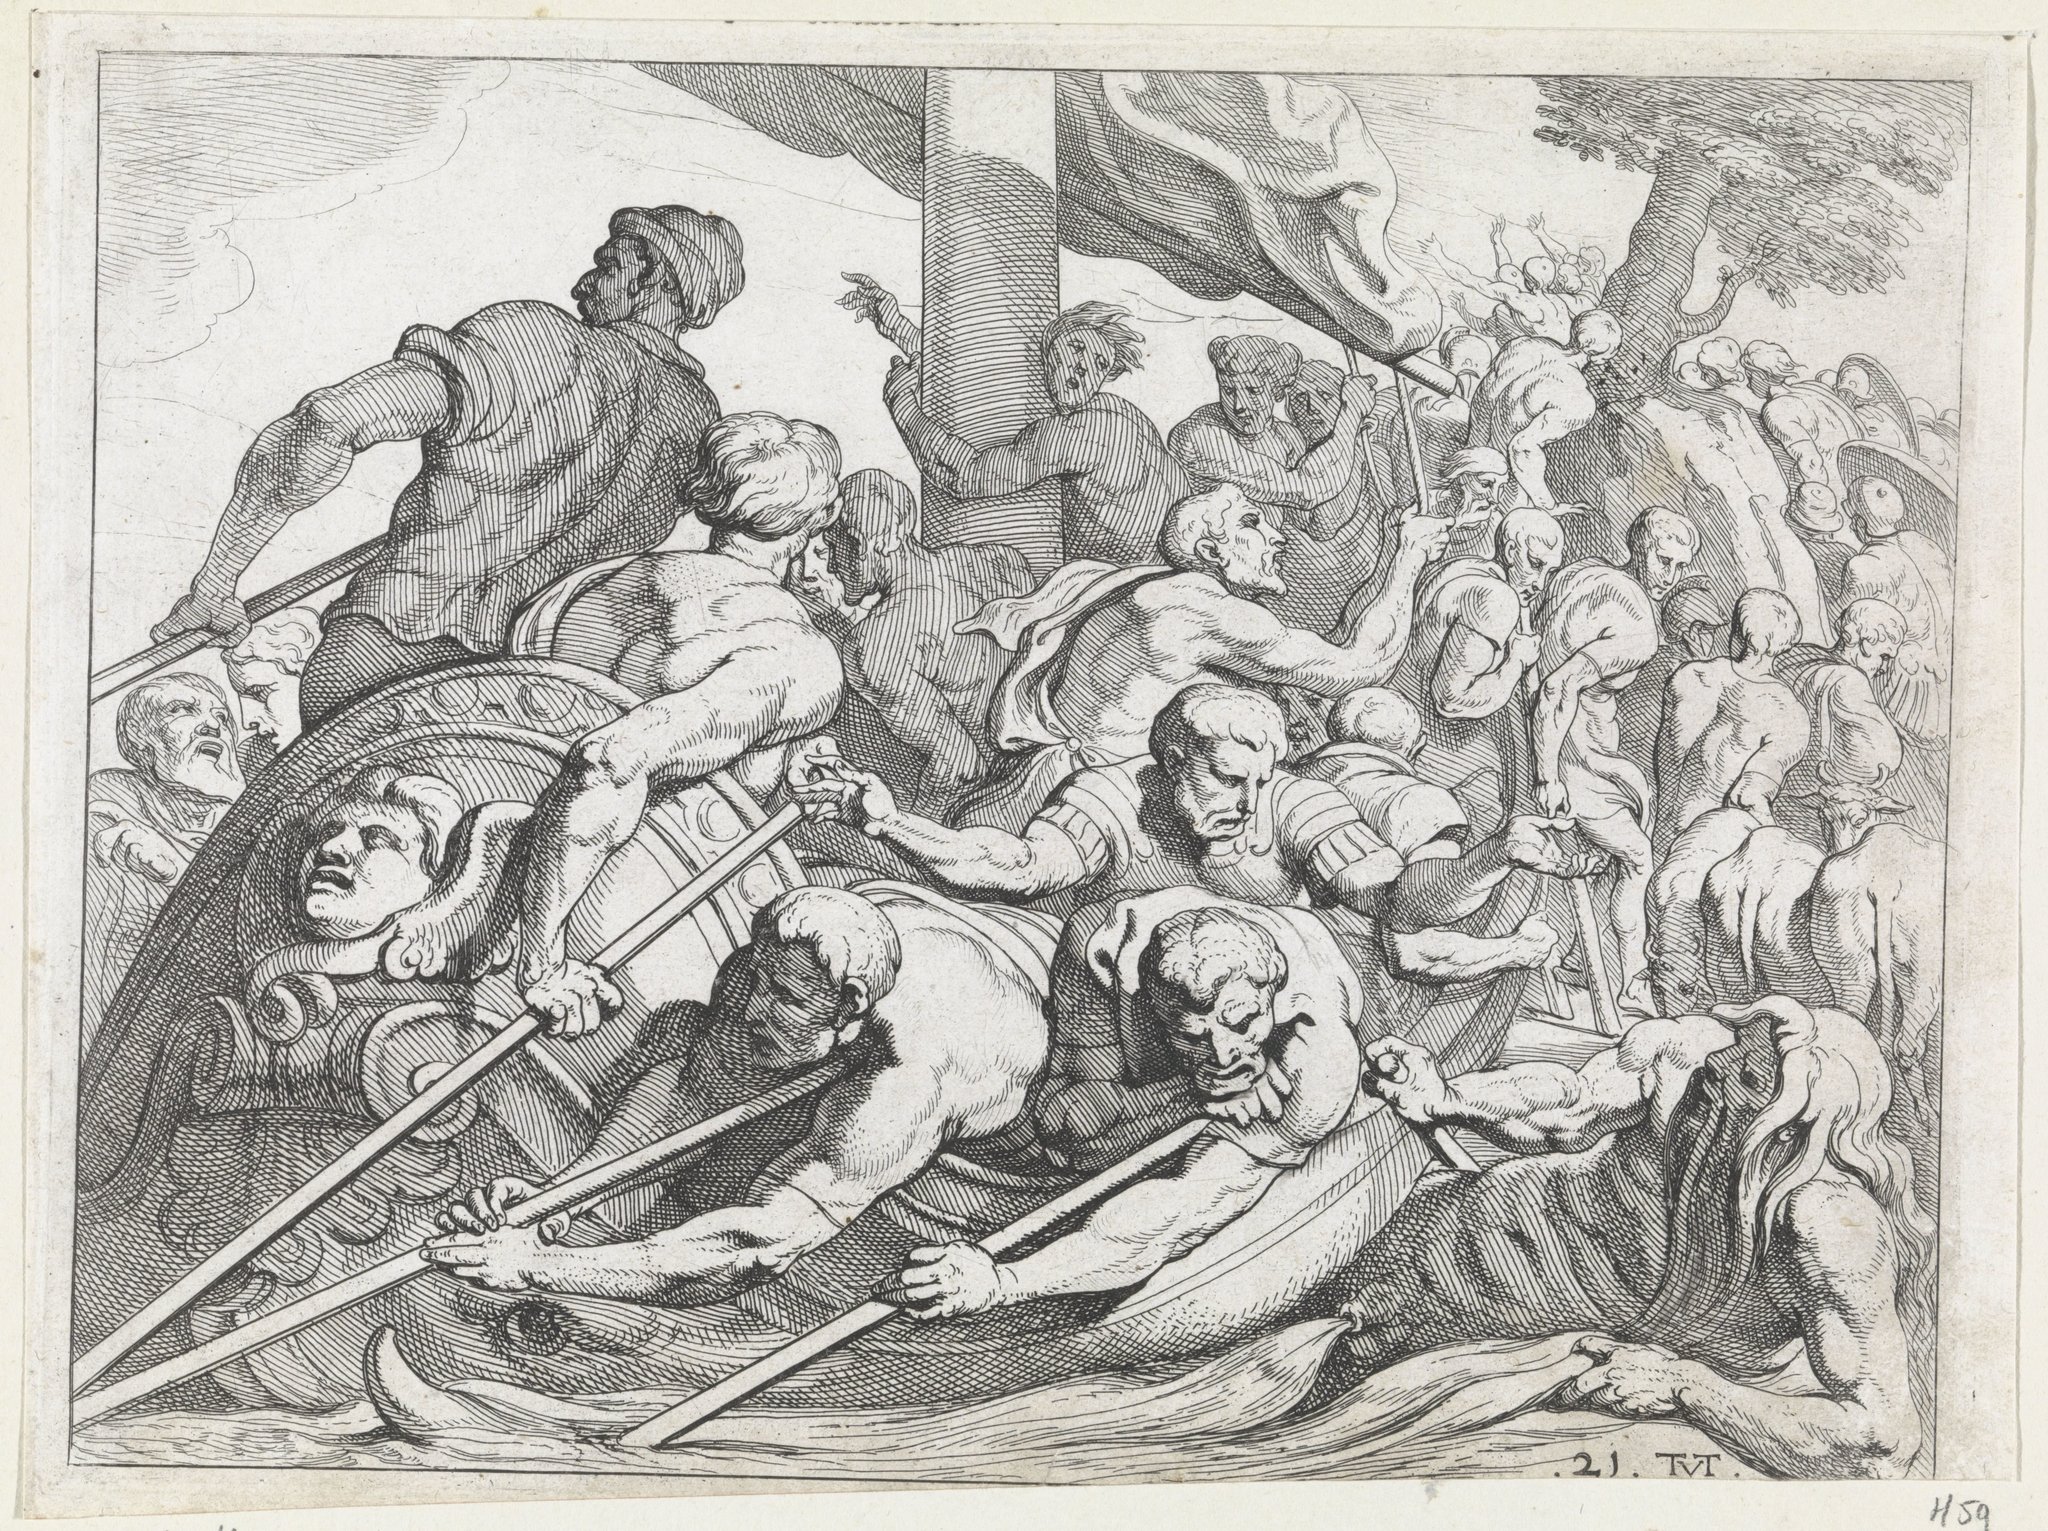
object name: print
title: Odysseus arriveert bij de onderwereld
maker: theodoor van thulden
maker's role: draughtsman, painter, print maker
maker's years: 1606-1669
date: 1632-1633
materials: paper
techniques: engraving, etching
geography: paris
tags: ulysses in the underworld (homer, odyssey xi)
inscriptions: collector's mark: Lugt 2228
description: De schepen van Odysseus en zijn mannen leggen aan, alvorens Odysseus in de onderwereld zal afdalen. Een van de schepen komt Neptunus tegen, die het schip dwarsligt.